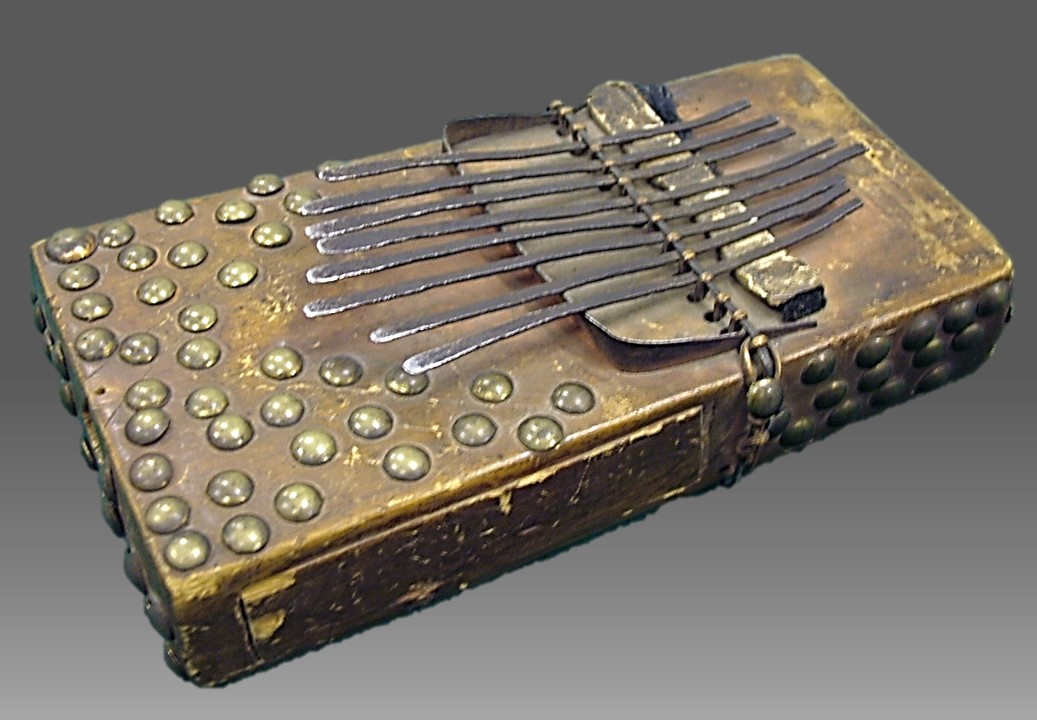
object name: likembe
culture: bateke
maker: bateke people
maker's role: culture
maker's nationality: congo, africa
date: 1867-1900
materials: metal, wood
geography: congo